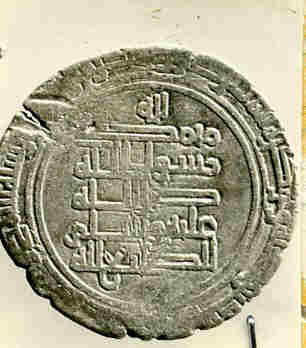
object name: coin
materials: silver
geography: arrijan